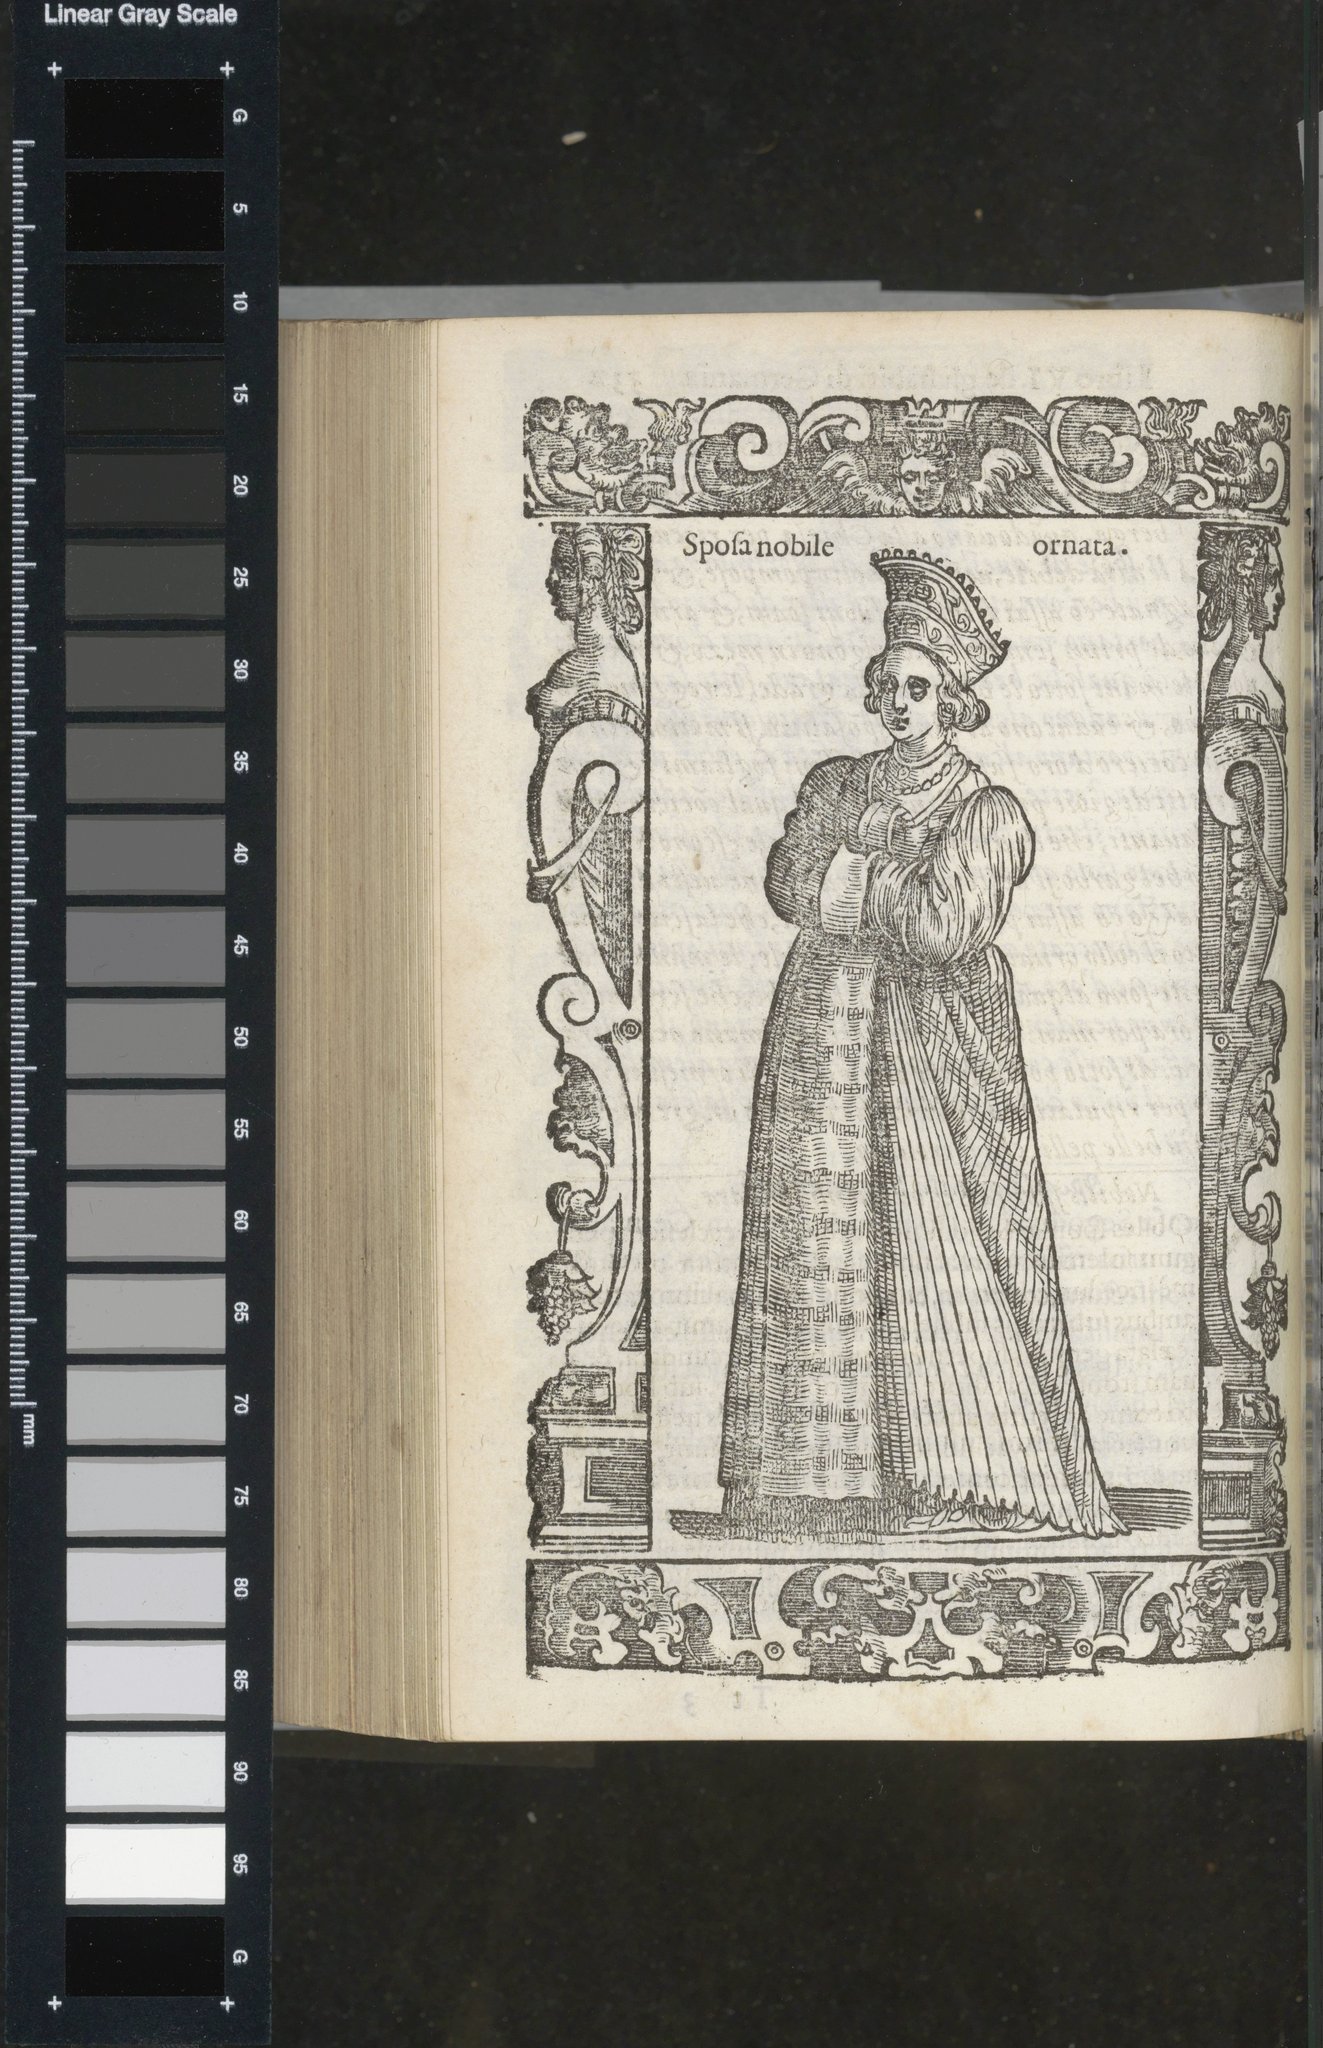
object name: costume print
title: Habiti antichi, et moderni di tutto il mondo...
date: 1598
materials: paper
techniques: woodcut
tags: fashion plates